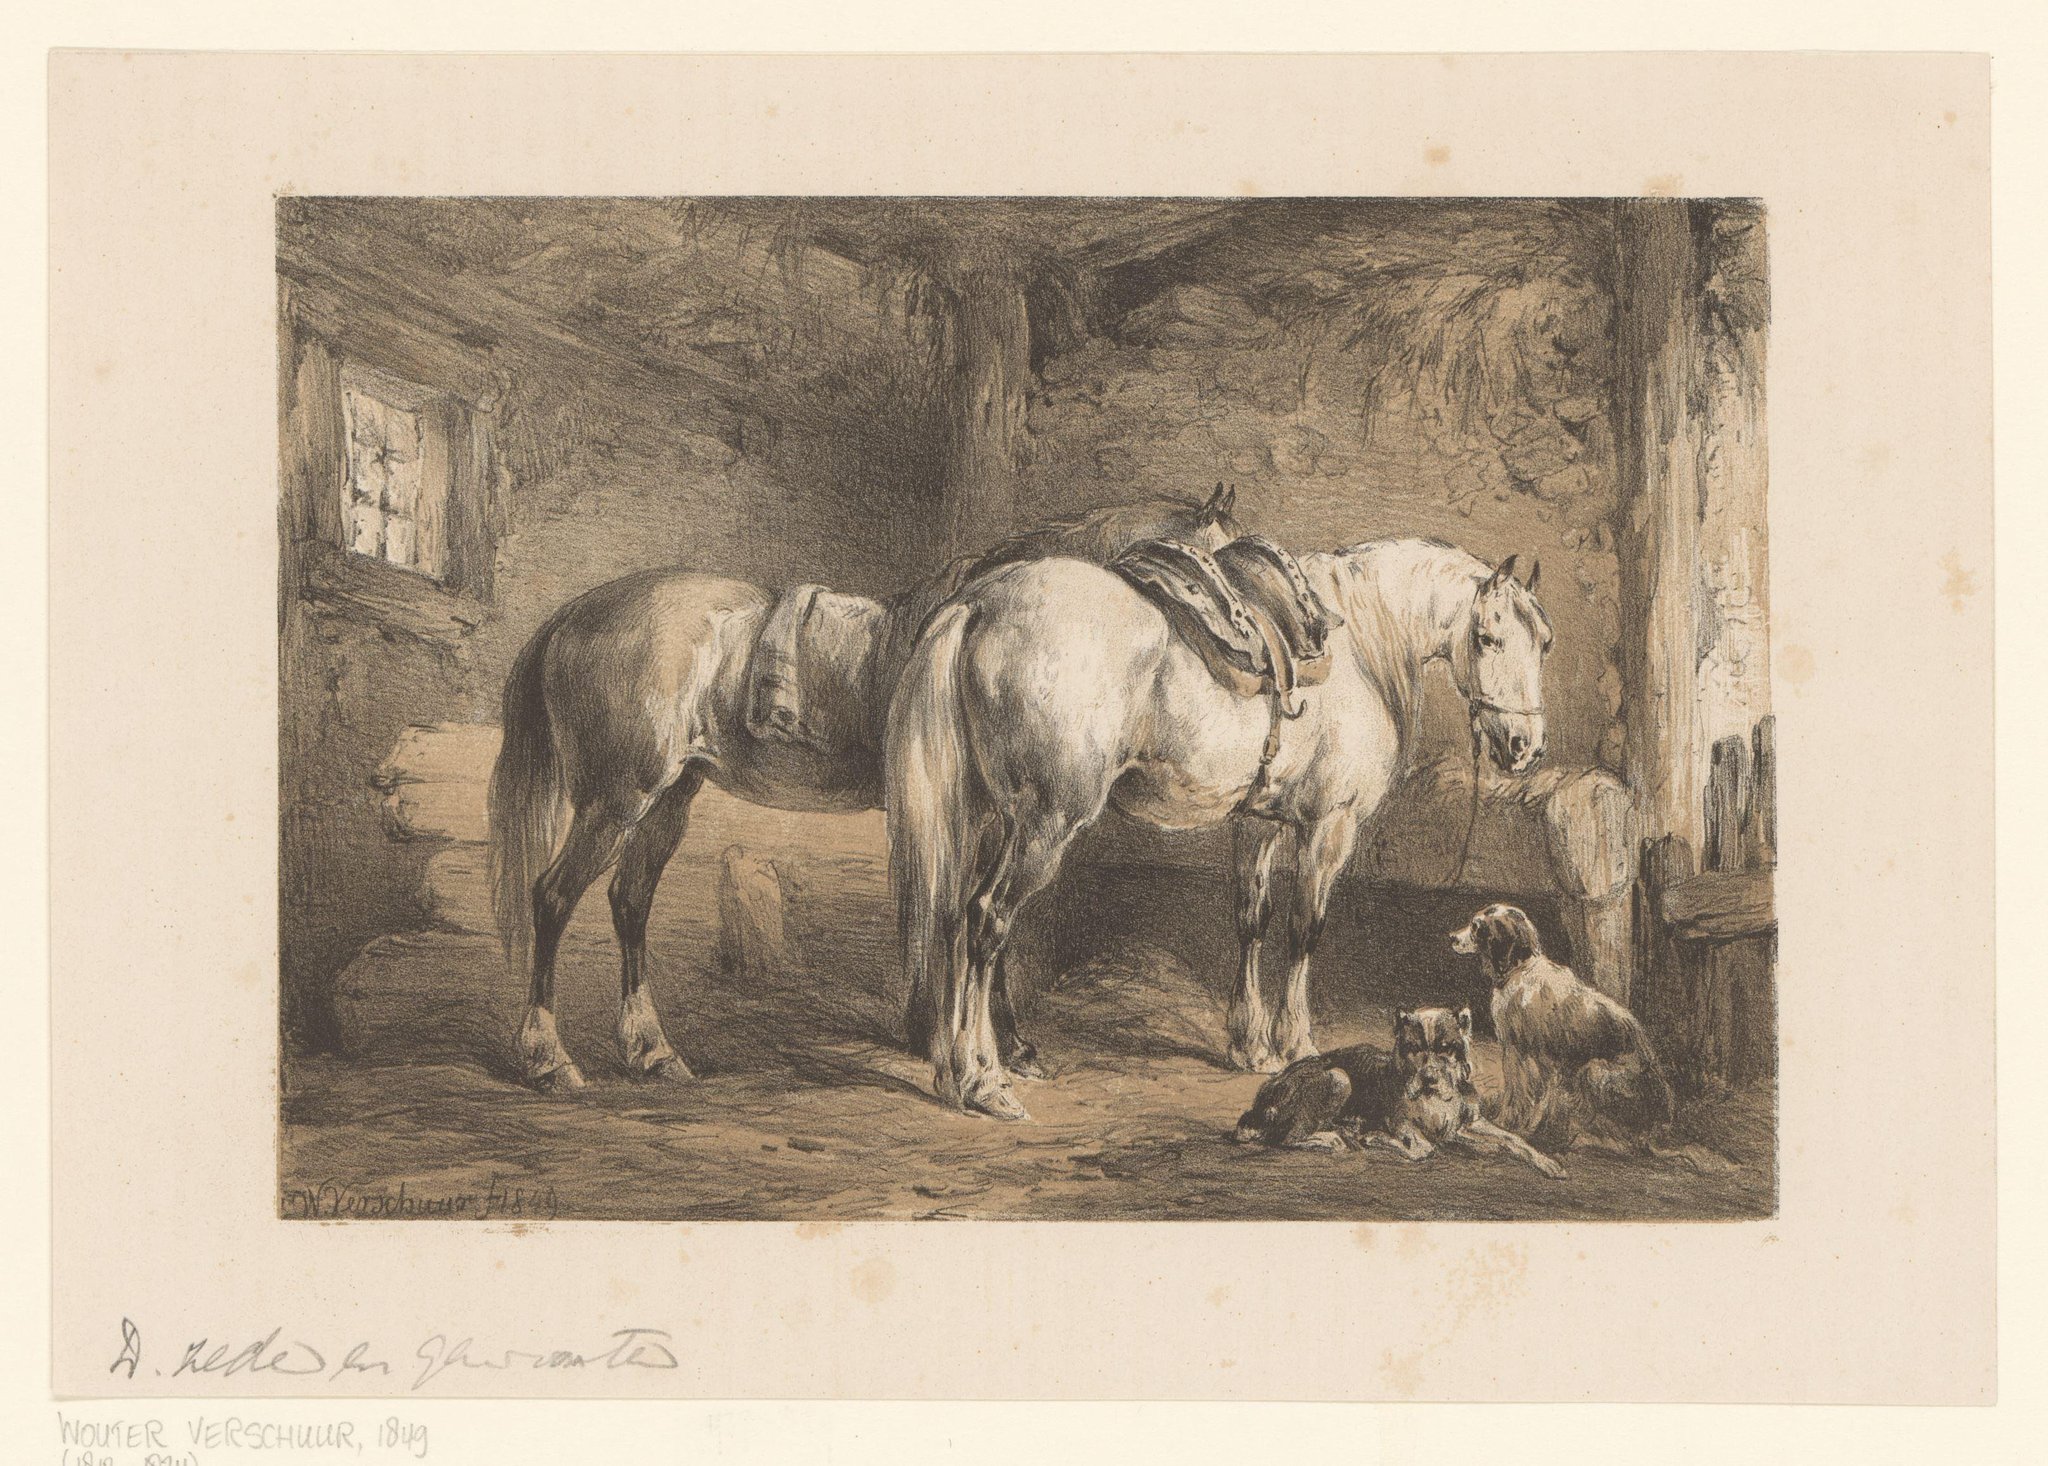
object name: print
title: Twee paarden en honden in een stal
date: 1849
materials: paper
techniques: tone lithography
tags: barn, dog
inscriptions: collector's mark: Lugt 2760, collector's mark: Lugt 2228